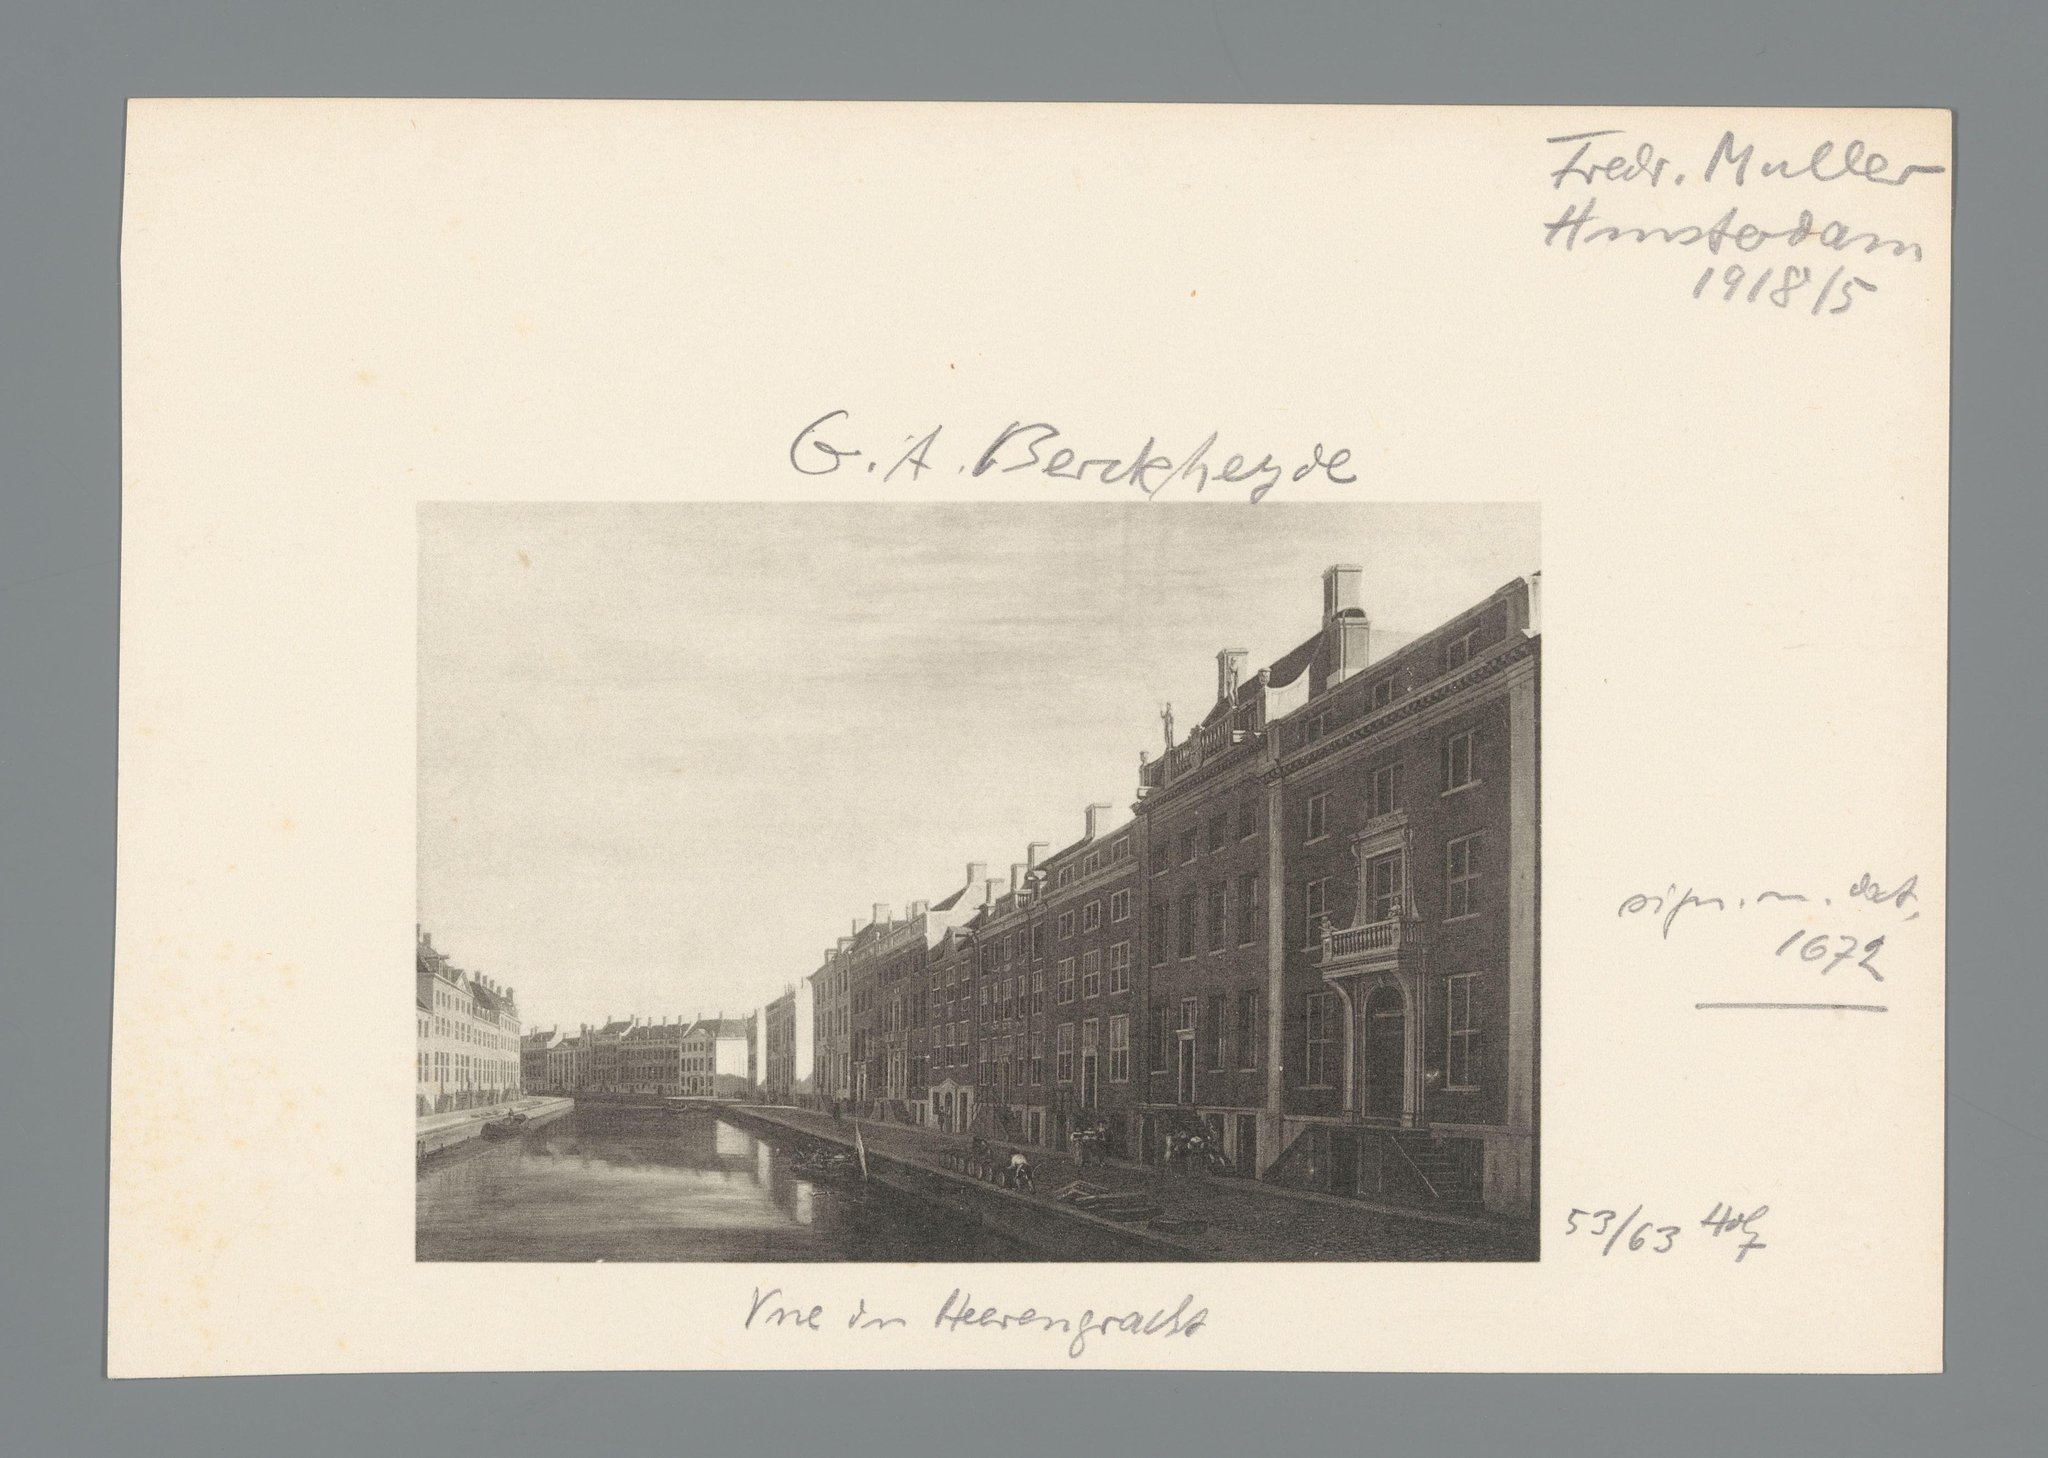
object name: photomechanical print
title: Gezicht op de Gouden Bocht in de Herengracht vanuit het westen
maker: Anonymous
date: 1850-1950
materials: paper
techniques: photograph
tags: canals, waters (in city)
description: Afdruk van een schilderij van G.A. Berkcheyde uit 1672.